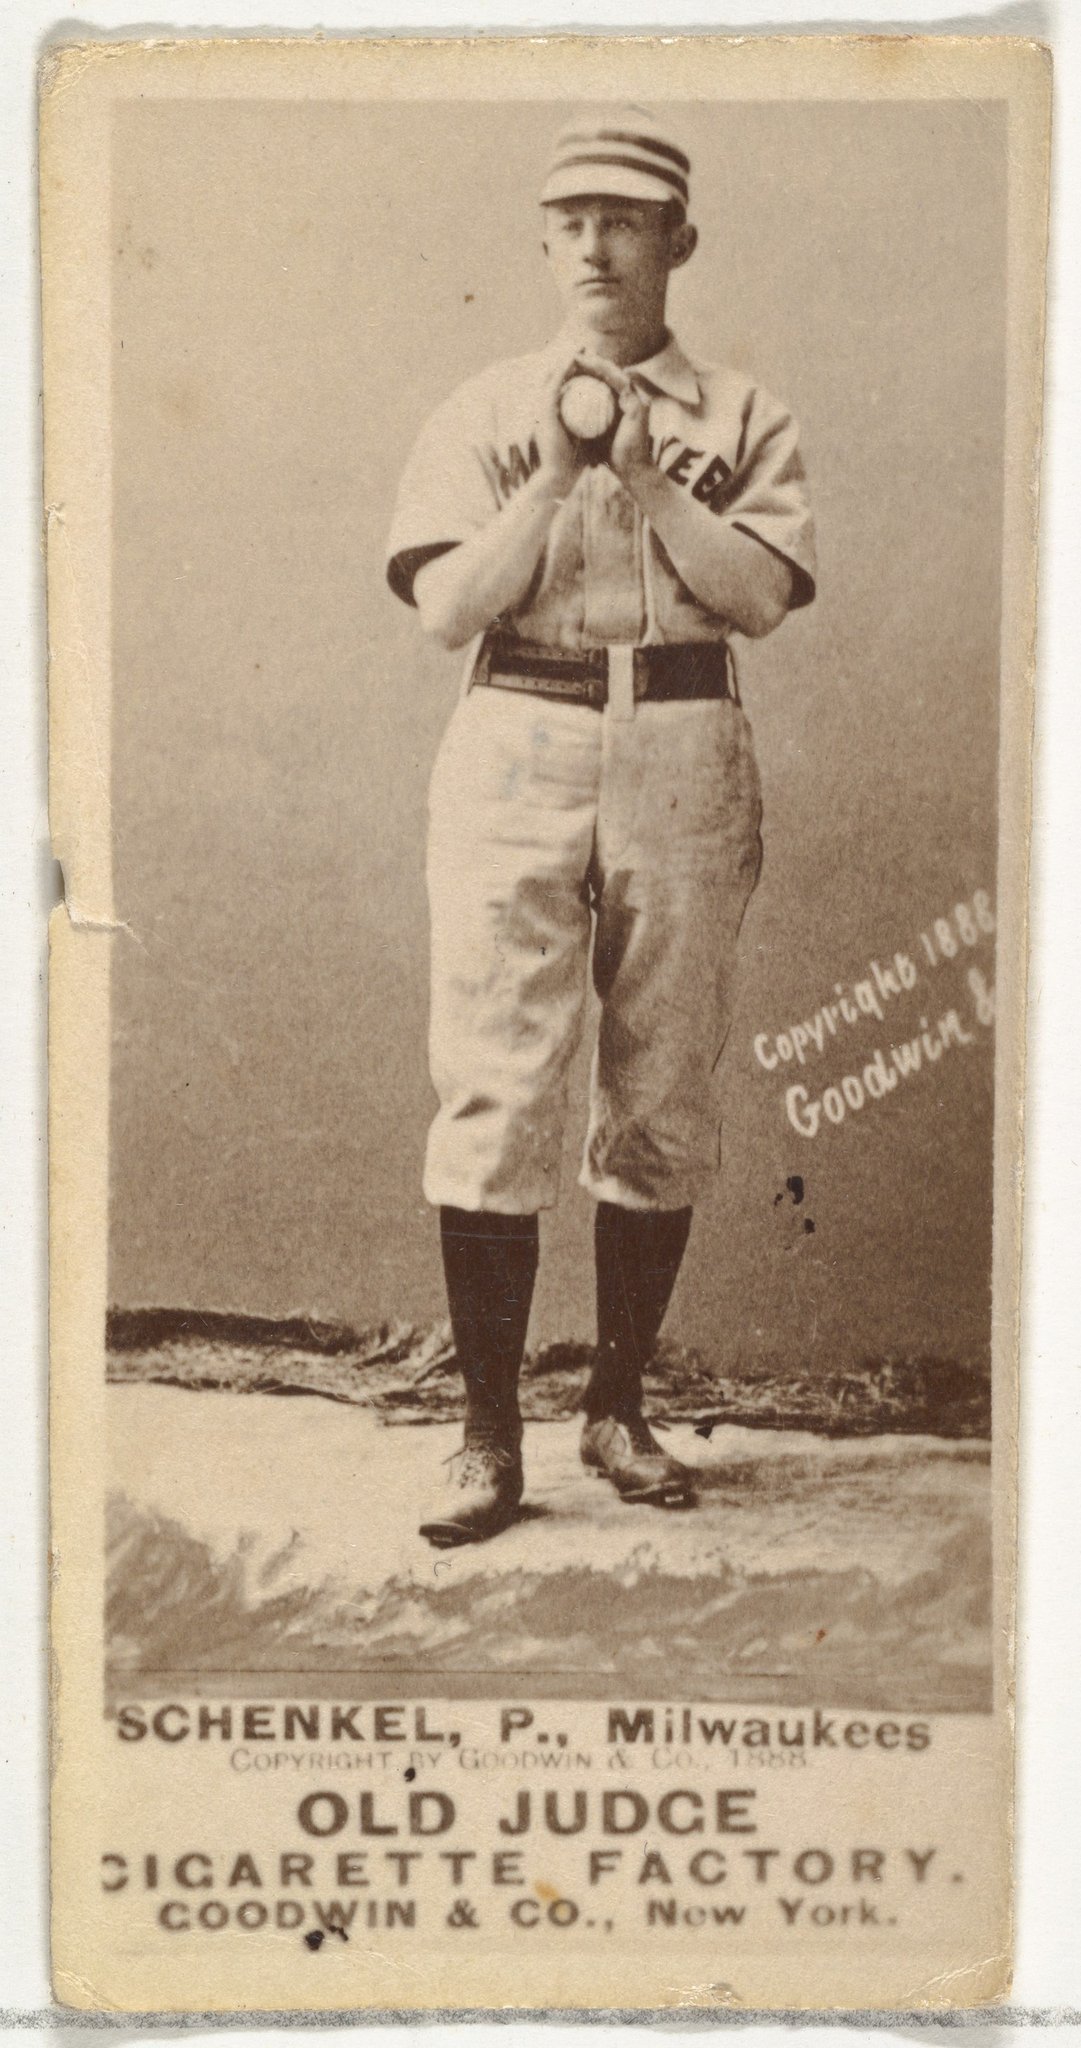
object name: baseball card, photograph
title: William Shenkel, Pitcher, Milwaukee, from the Old Judge series (N172) for Old Judge Cigarettes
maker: goodwin & company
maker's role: publisher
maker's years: 1850-1950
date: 1888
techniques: albumen silver print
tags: men,portraits,baseball,athletes